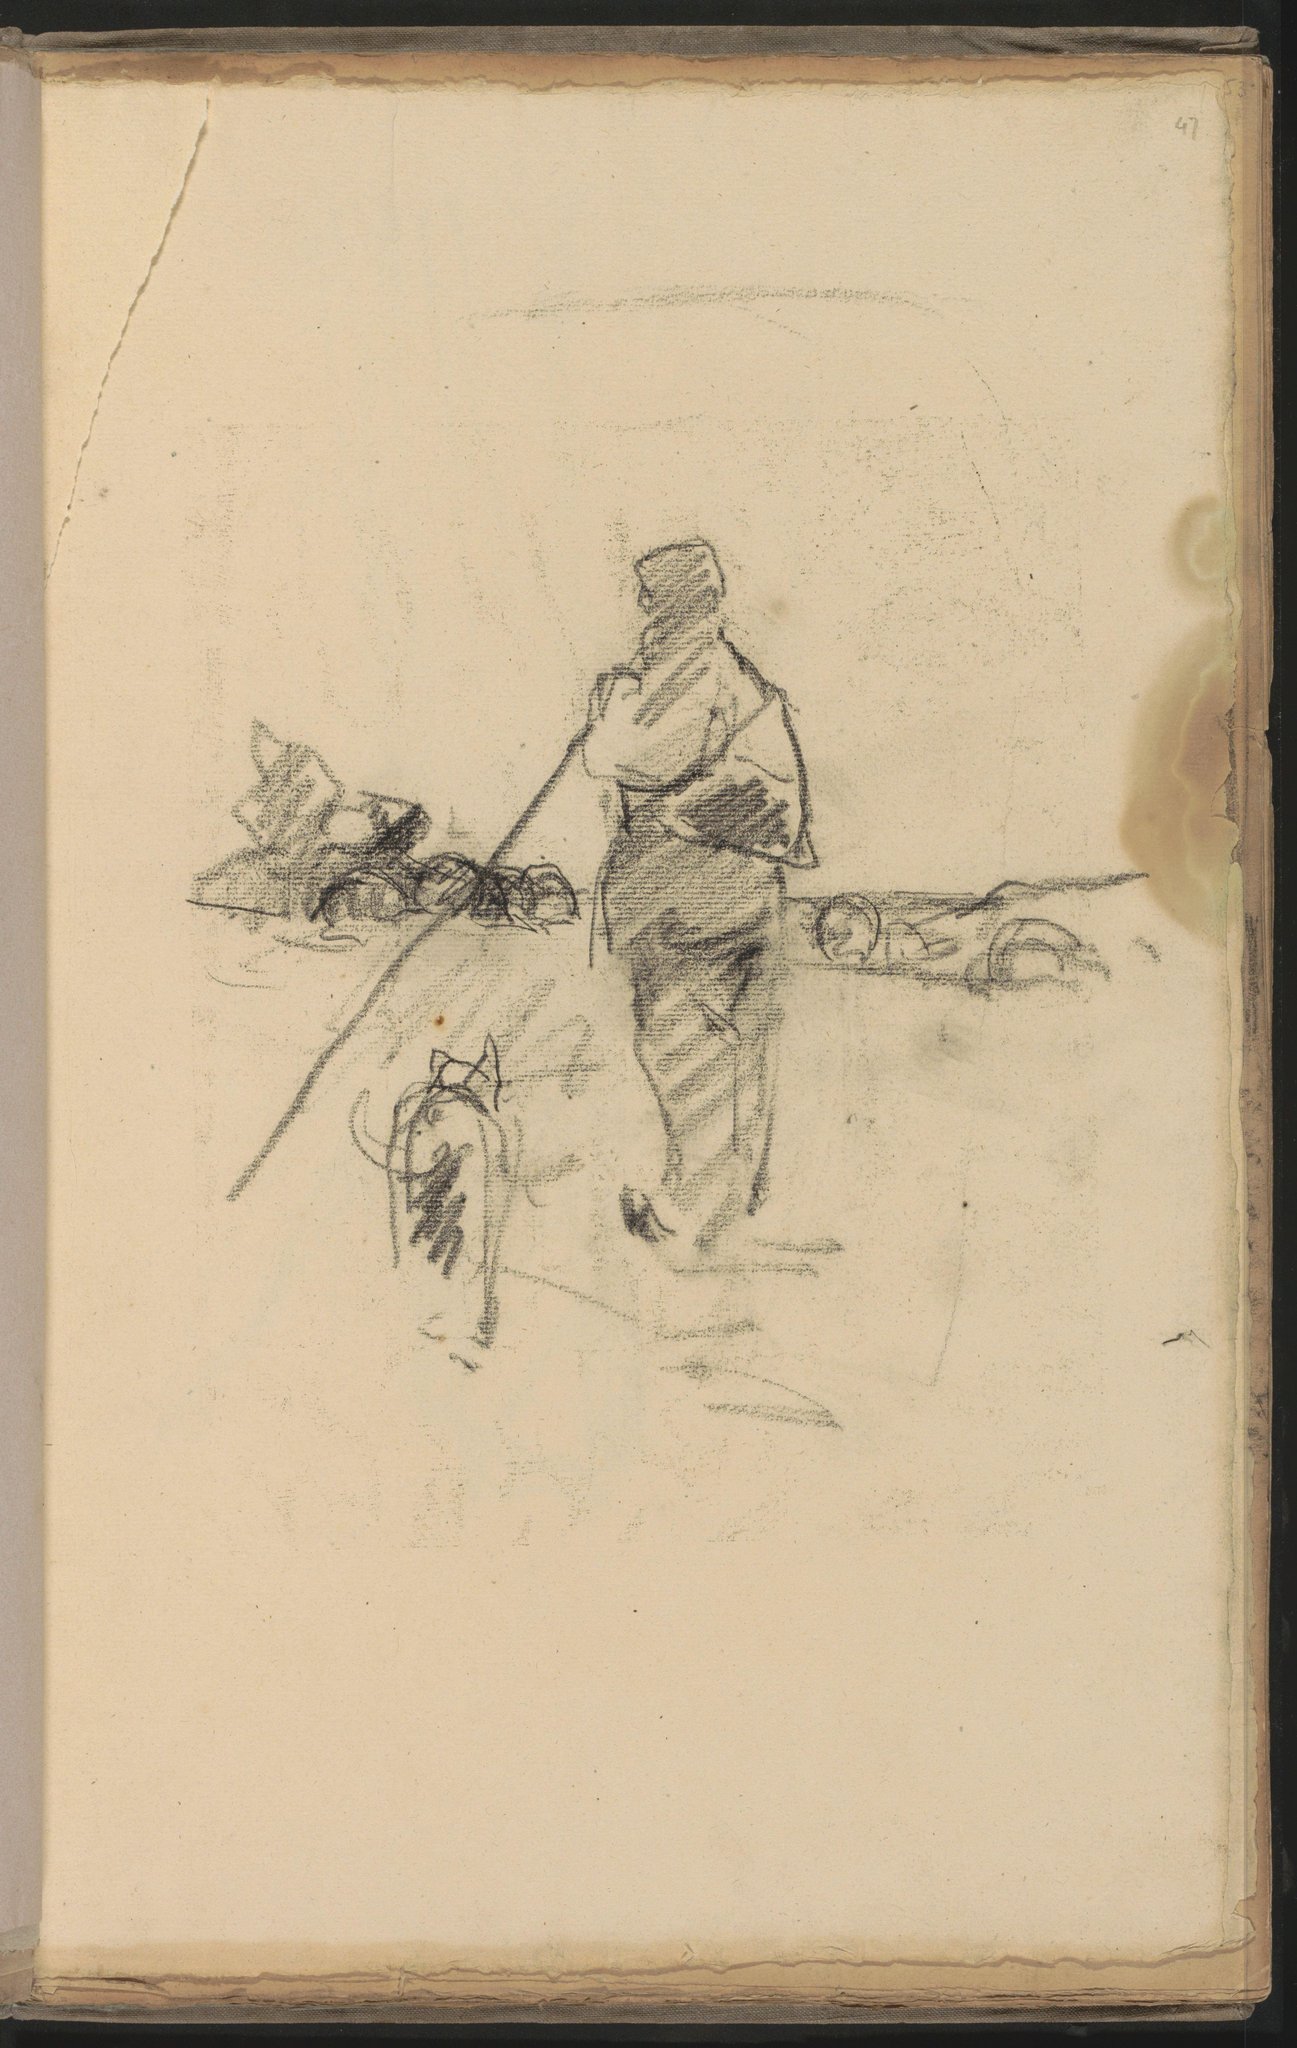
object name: sketchbook leaf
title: Schaapherder met zijn hond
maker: willem witsen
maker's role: draughtsman, painter, print maker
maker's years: 1860-1923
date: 1884-1887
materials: chalk, paper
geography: ewijkshoeve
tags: cattle driving, cattle driver, sheep, dog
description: Hij leunt op zijn staf. In de verte zijn kudde. Pagina 47 uit een schetsboek met 42 bladen vervaardigd rond de Ewijkshoeve.